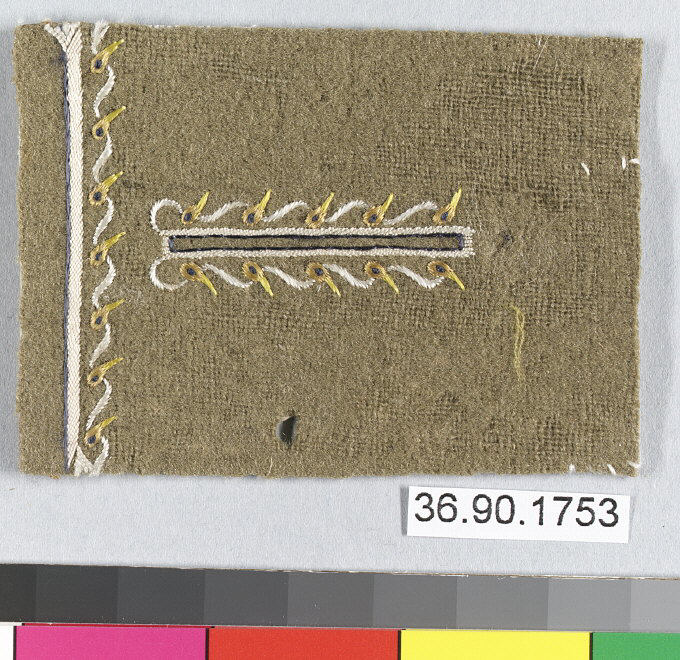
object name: sample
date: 1801-1833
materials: felt, silk